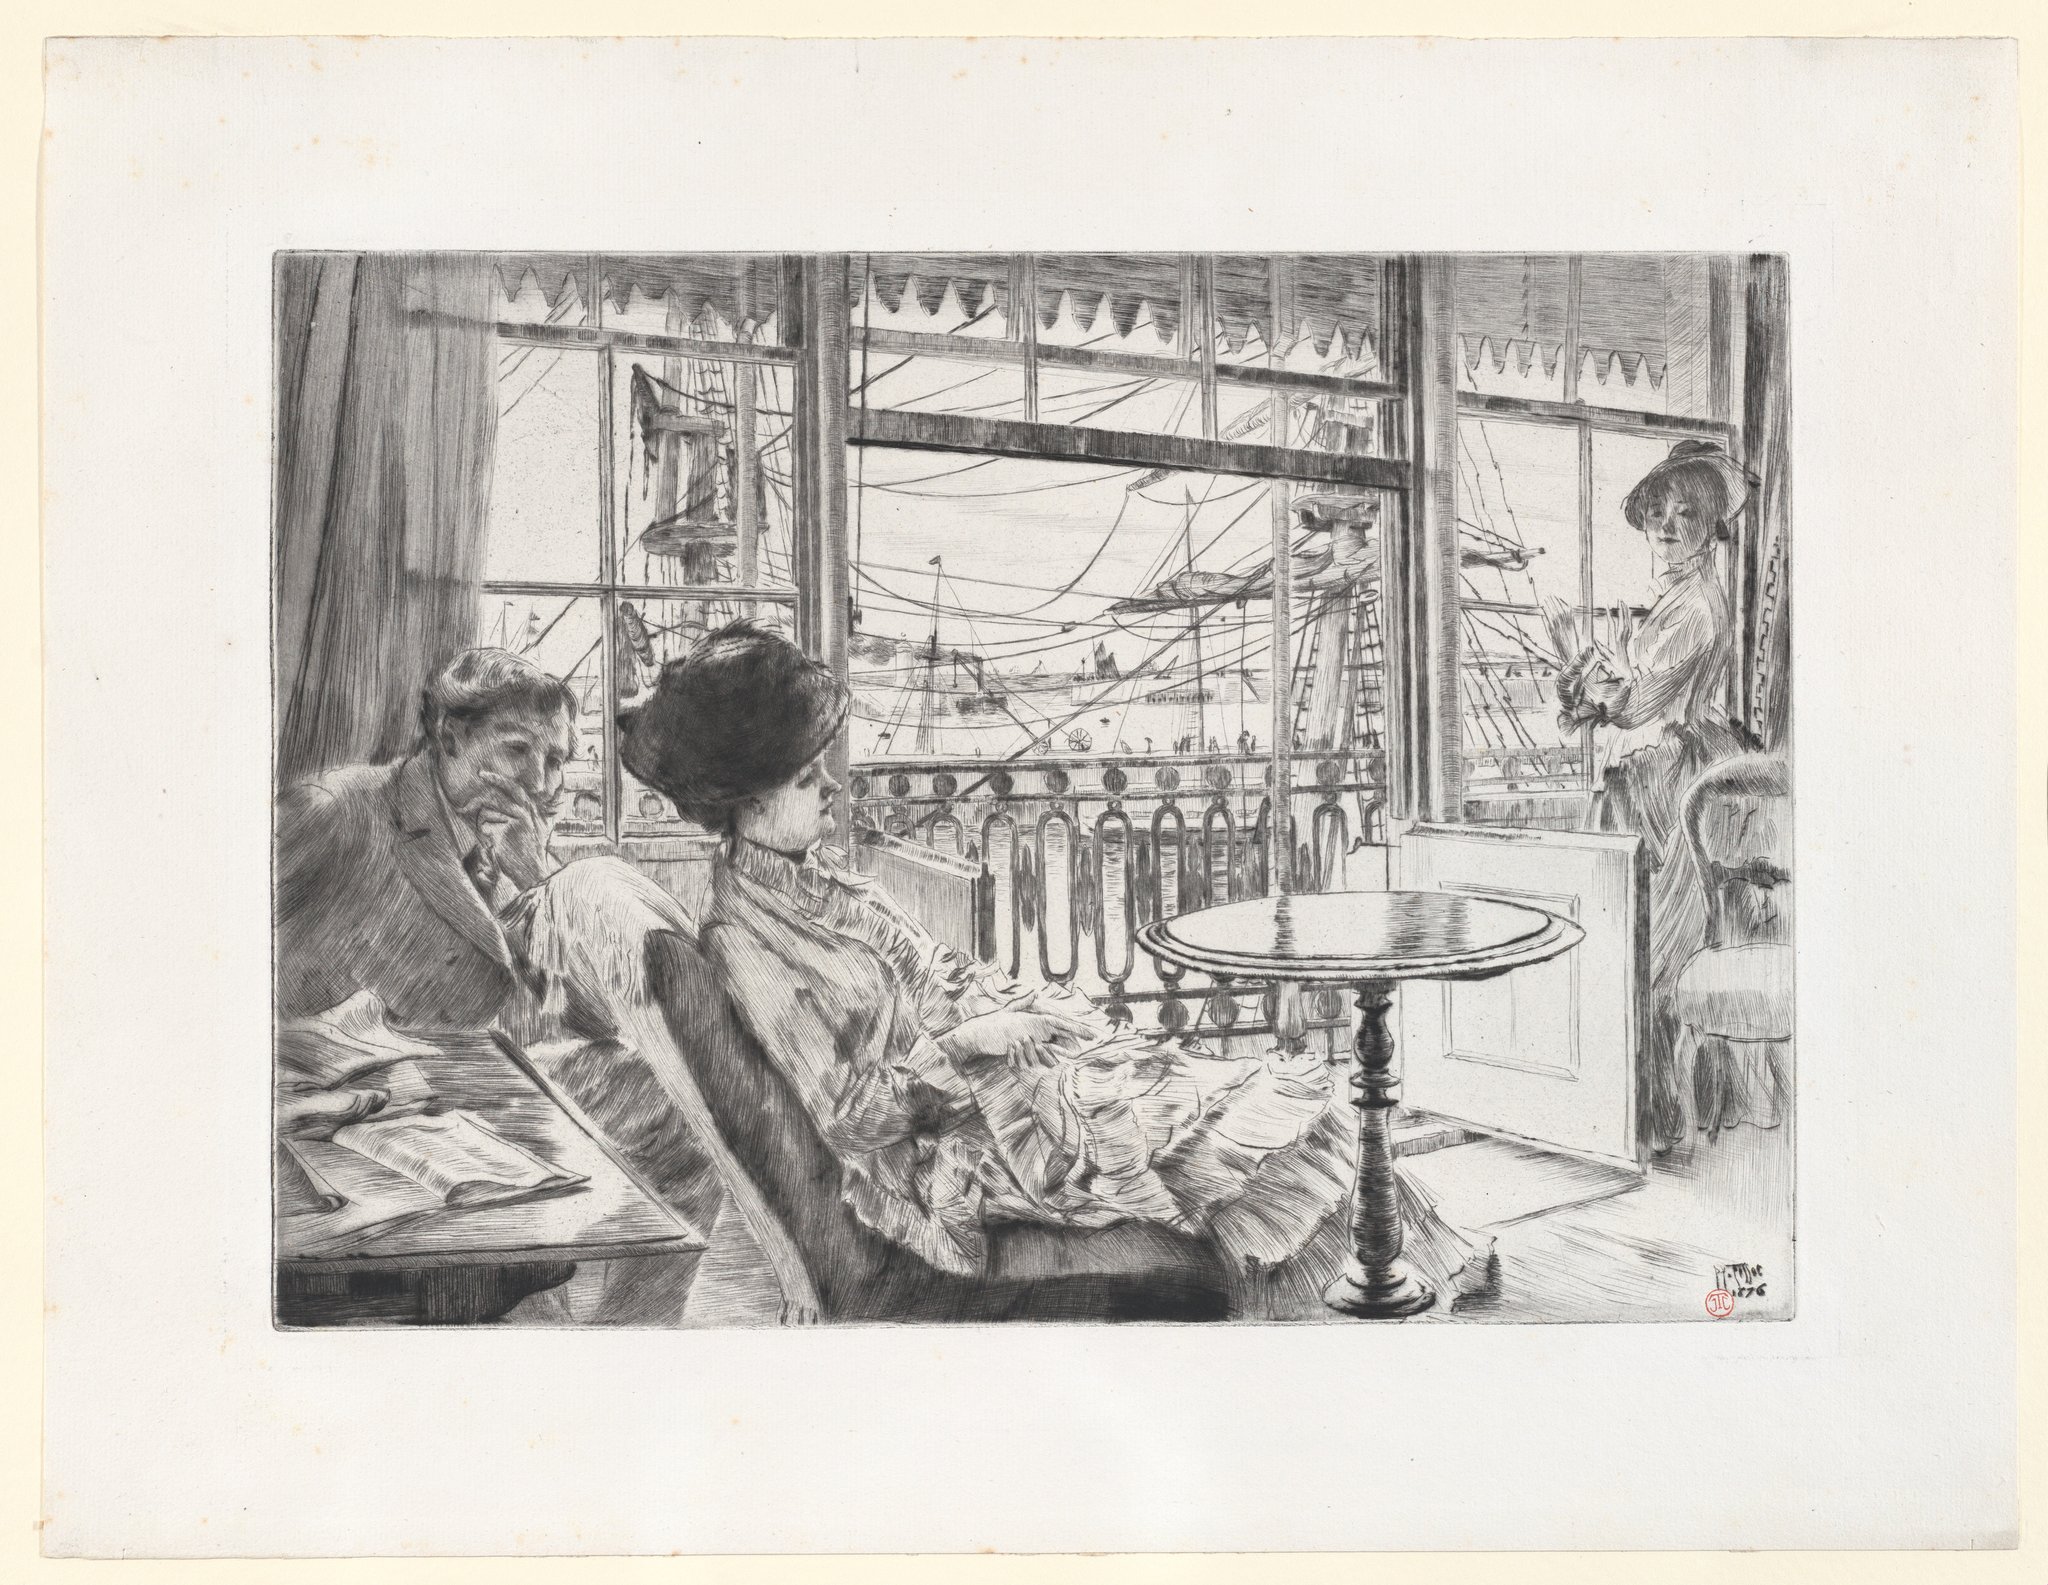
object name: print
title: Ramsgate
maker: james tissot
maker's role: artist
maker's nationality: french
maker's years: 1836-1902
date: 1876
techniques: drypoint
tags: interiors,men,women,ships